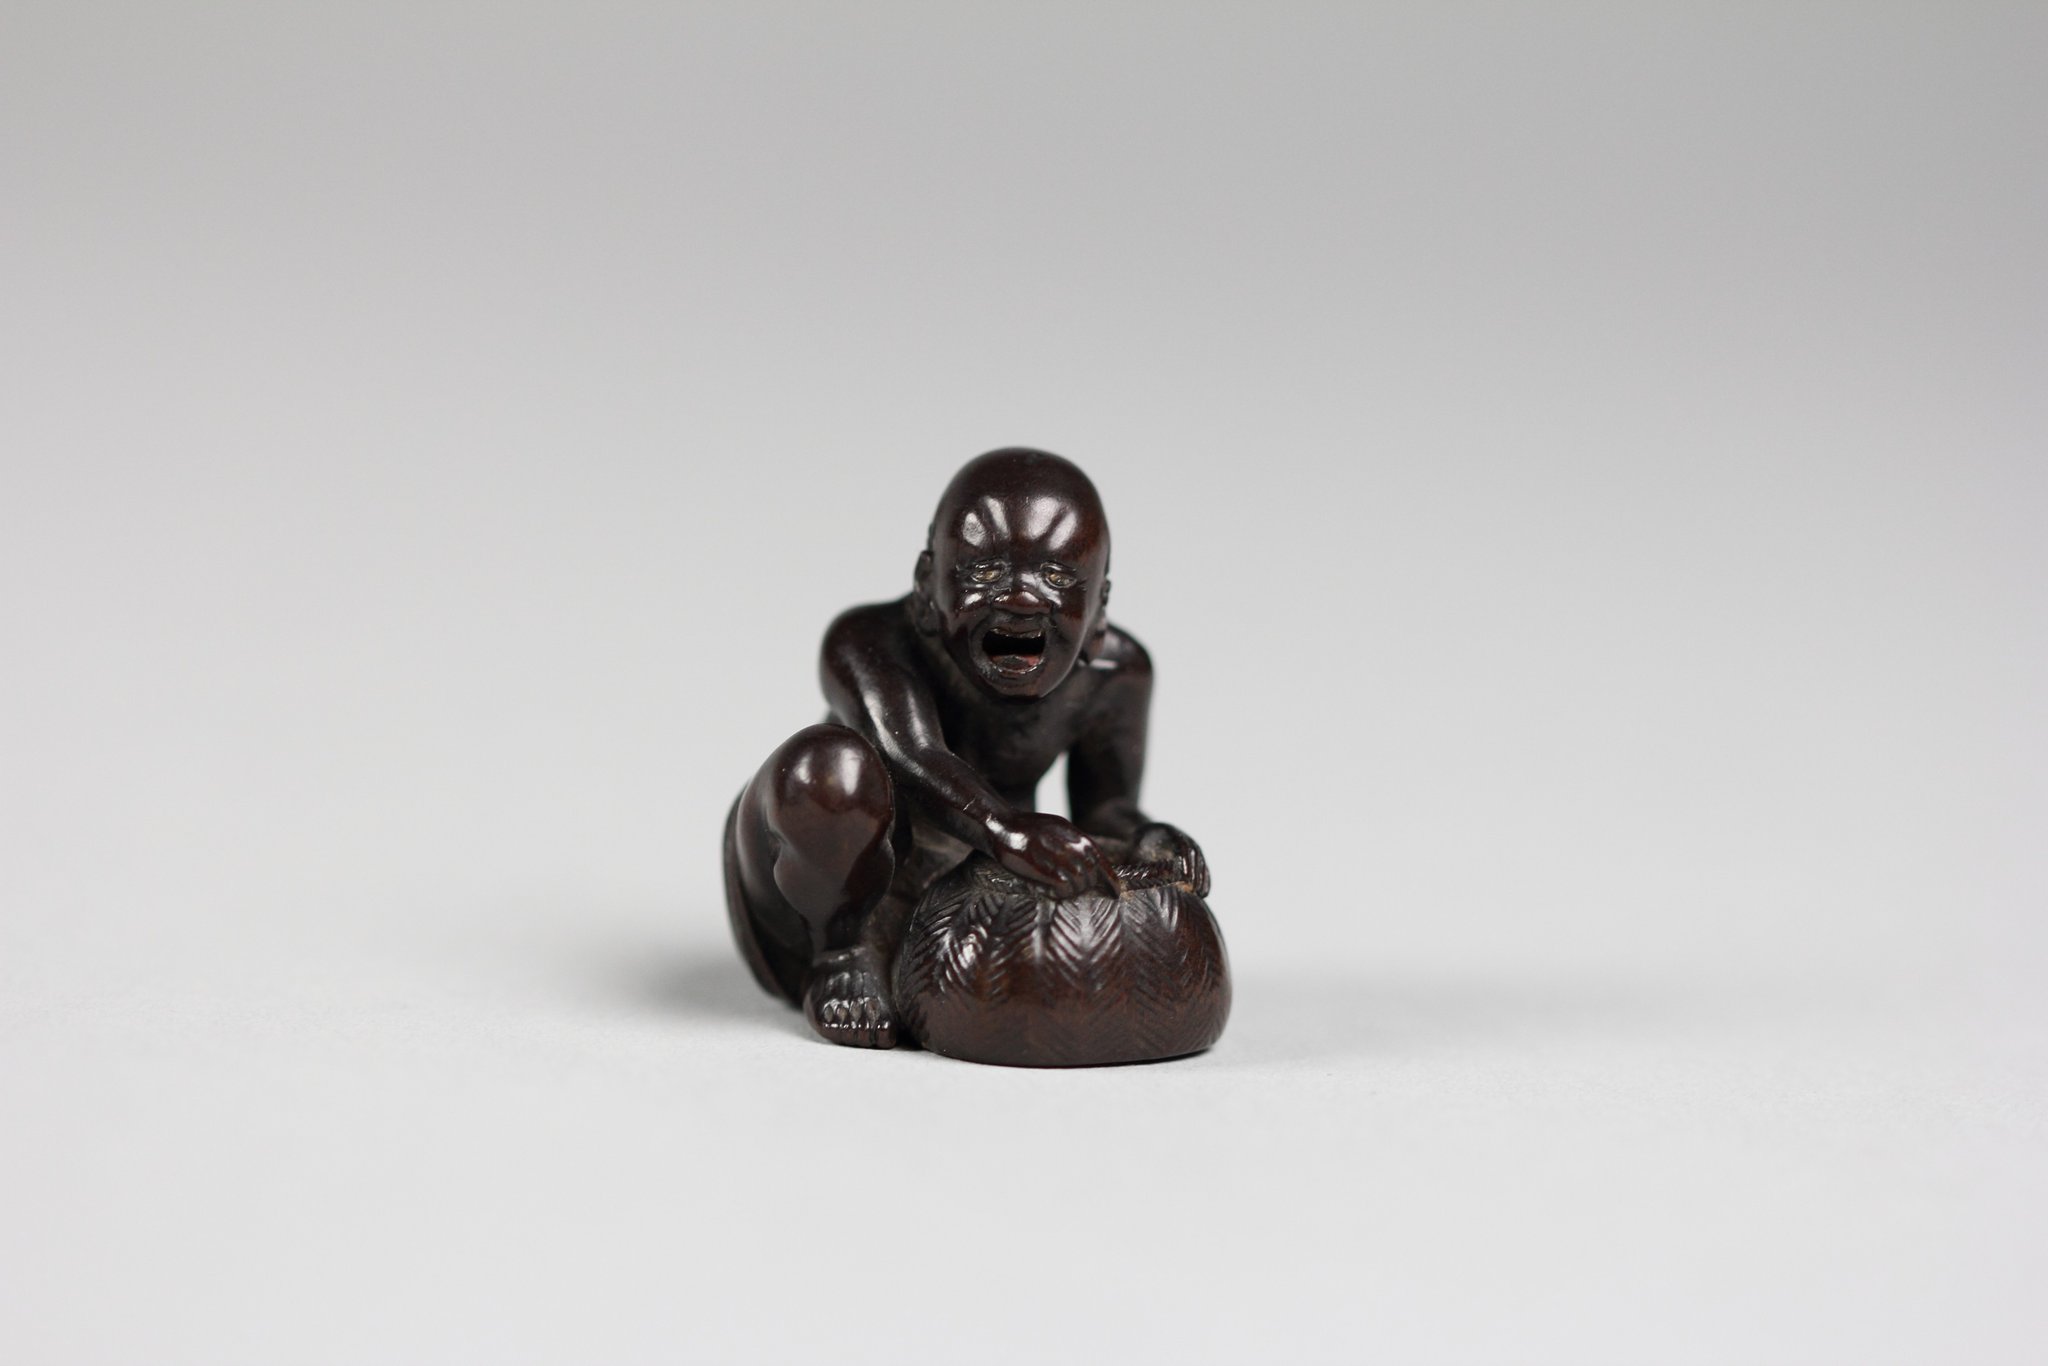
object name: netsuke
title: Netsuke of a South Sea Islander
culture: japanese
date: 1801-1900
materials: wood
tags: men